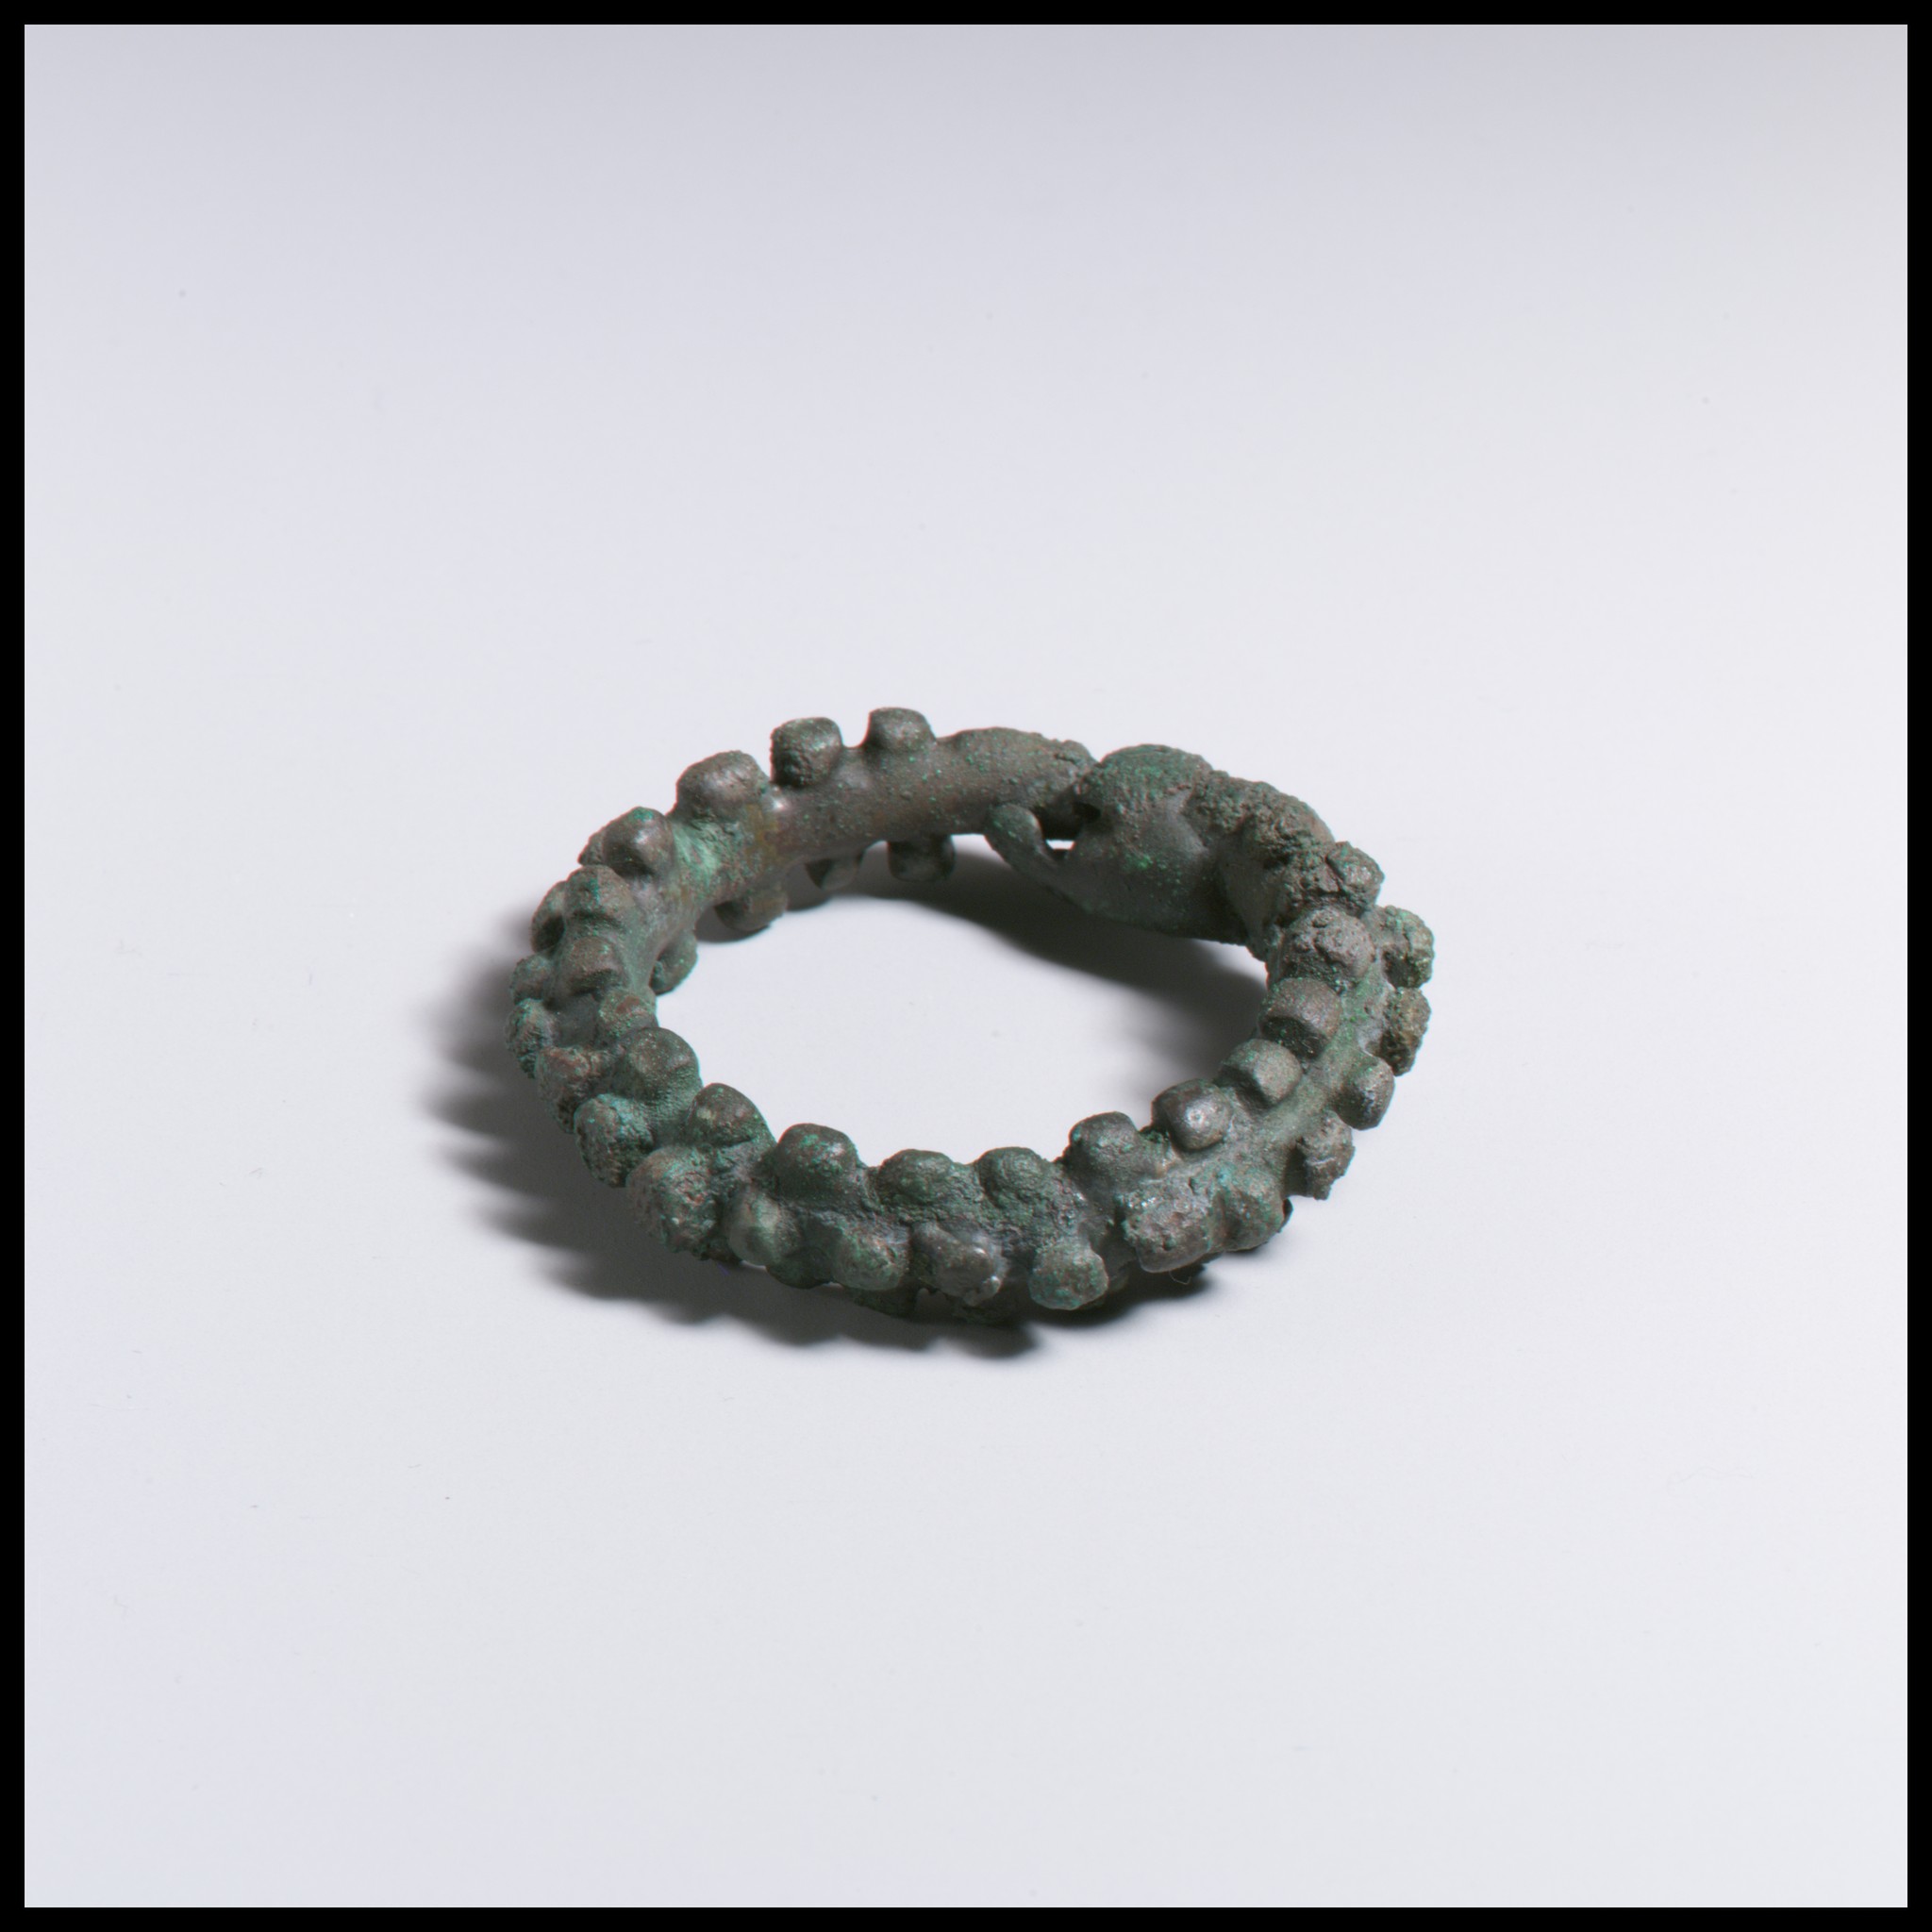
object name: bracelet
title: bronze bracelet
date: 7000 BCE-330 CE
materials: bronze